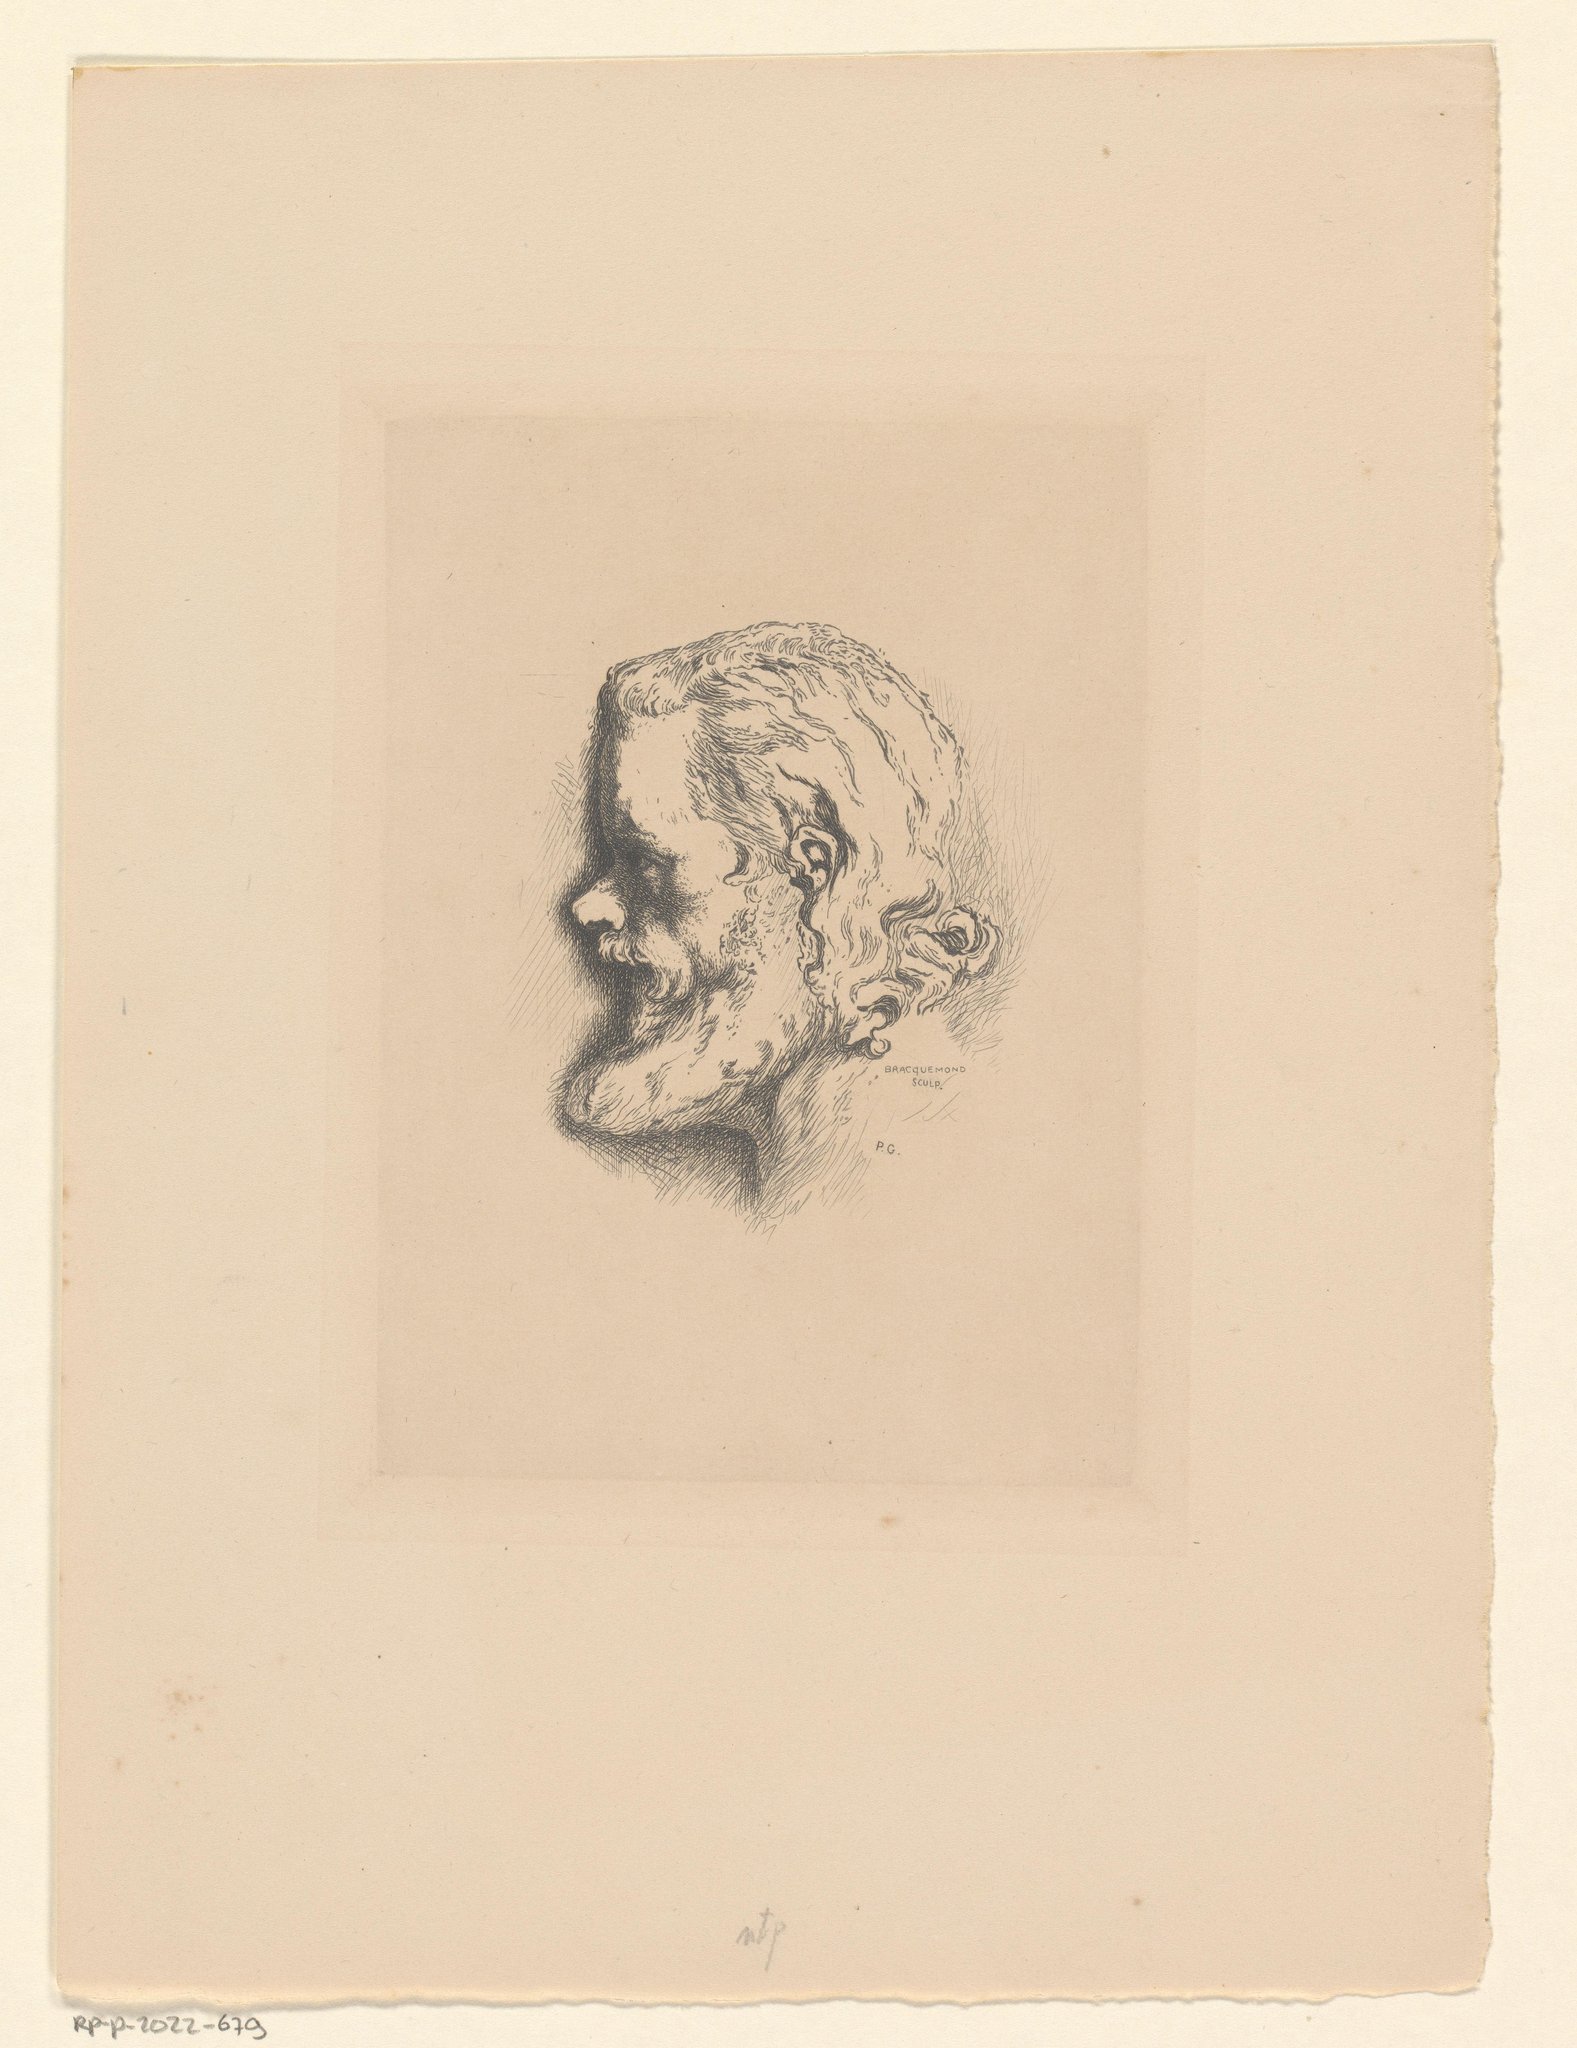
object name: print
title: Portret van Charles Meryon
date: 1848-1914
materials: paper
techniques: etching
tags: paris, print maker, charles meryon, historical persons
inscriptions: collector's mark: ‘[twee wapens, één met driemaal X]’, collector's mark: Lugt 2228